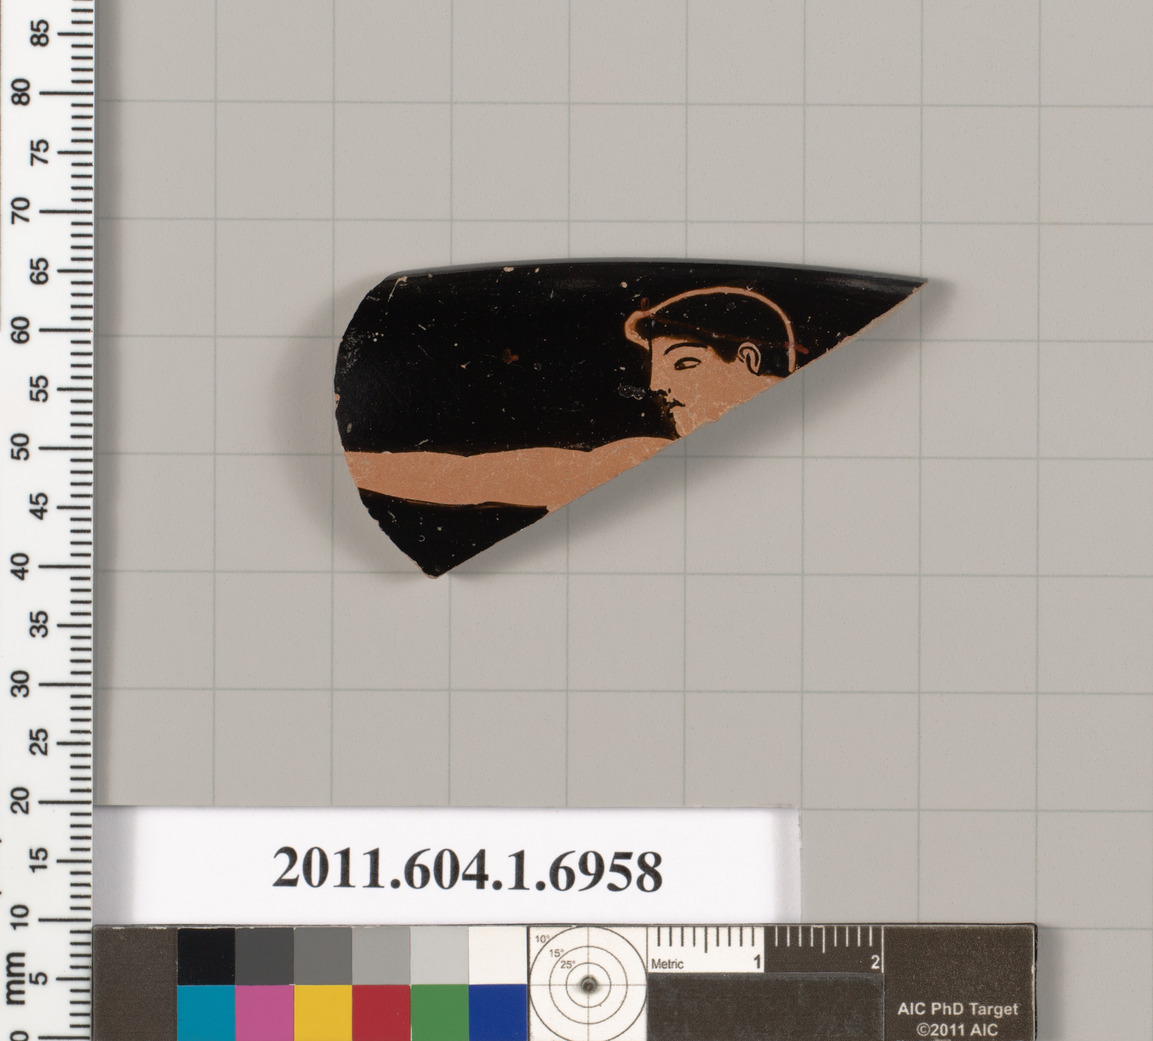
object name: kylix fragment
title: Terracotta rim fragment of a kylix (drinking cup)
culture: greek, attic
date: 490-470 BCE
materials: terracotta